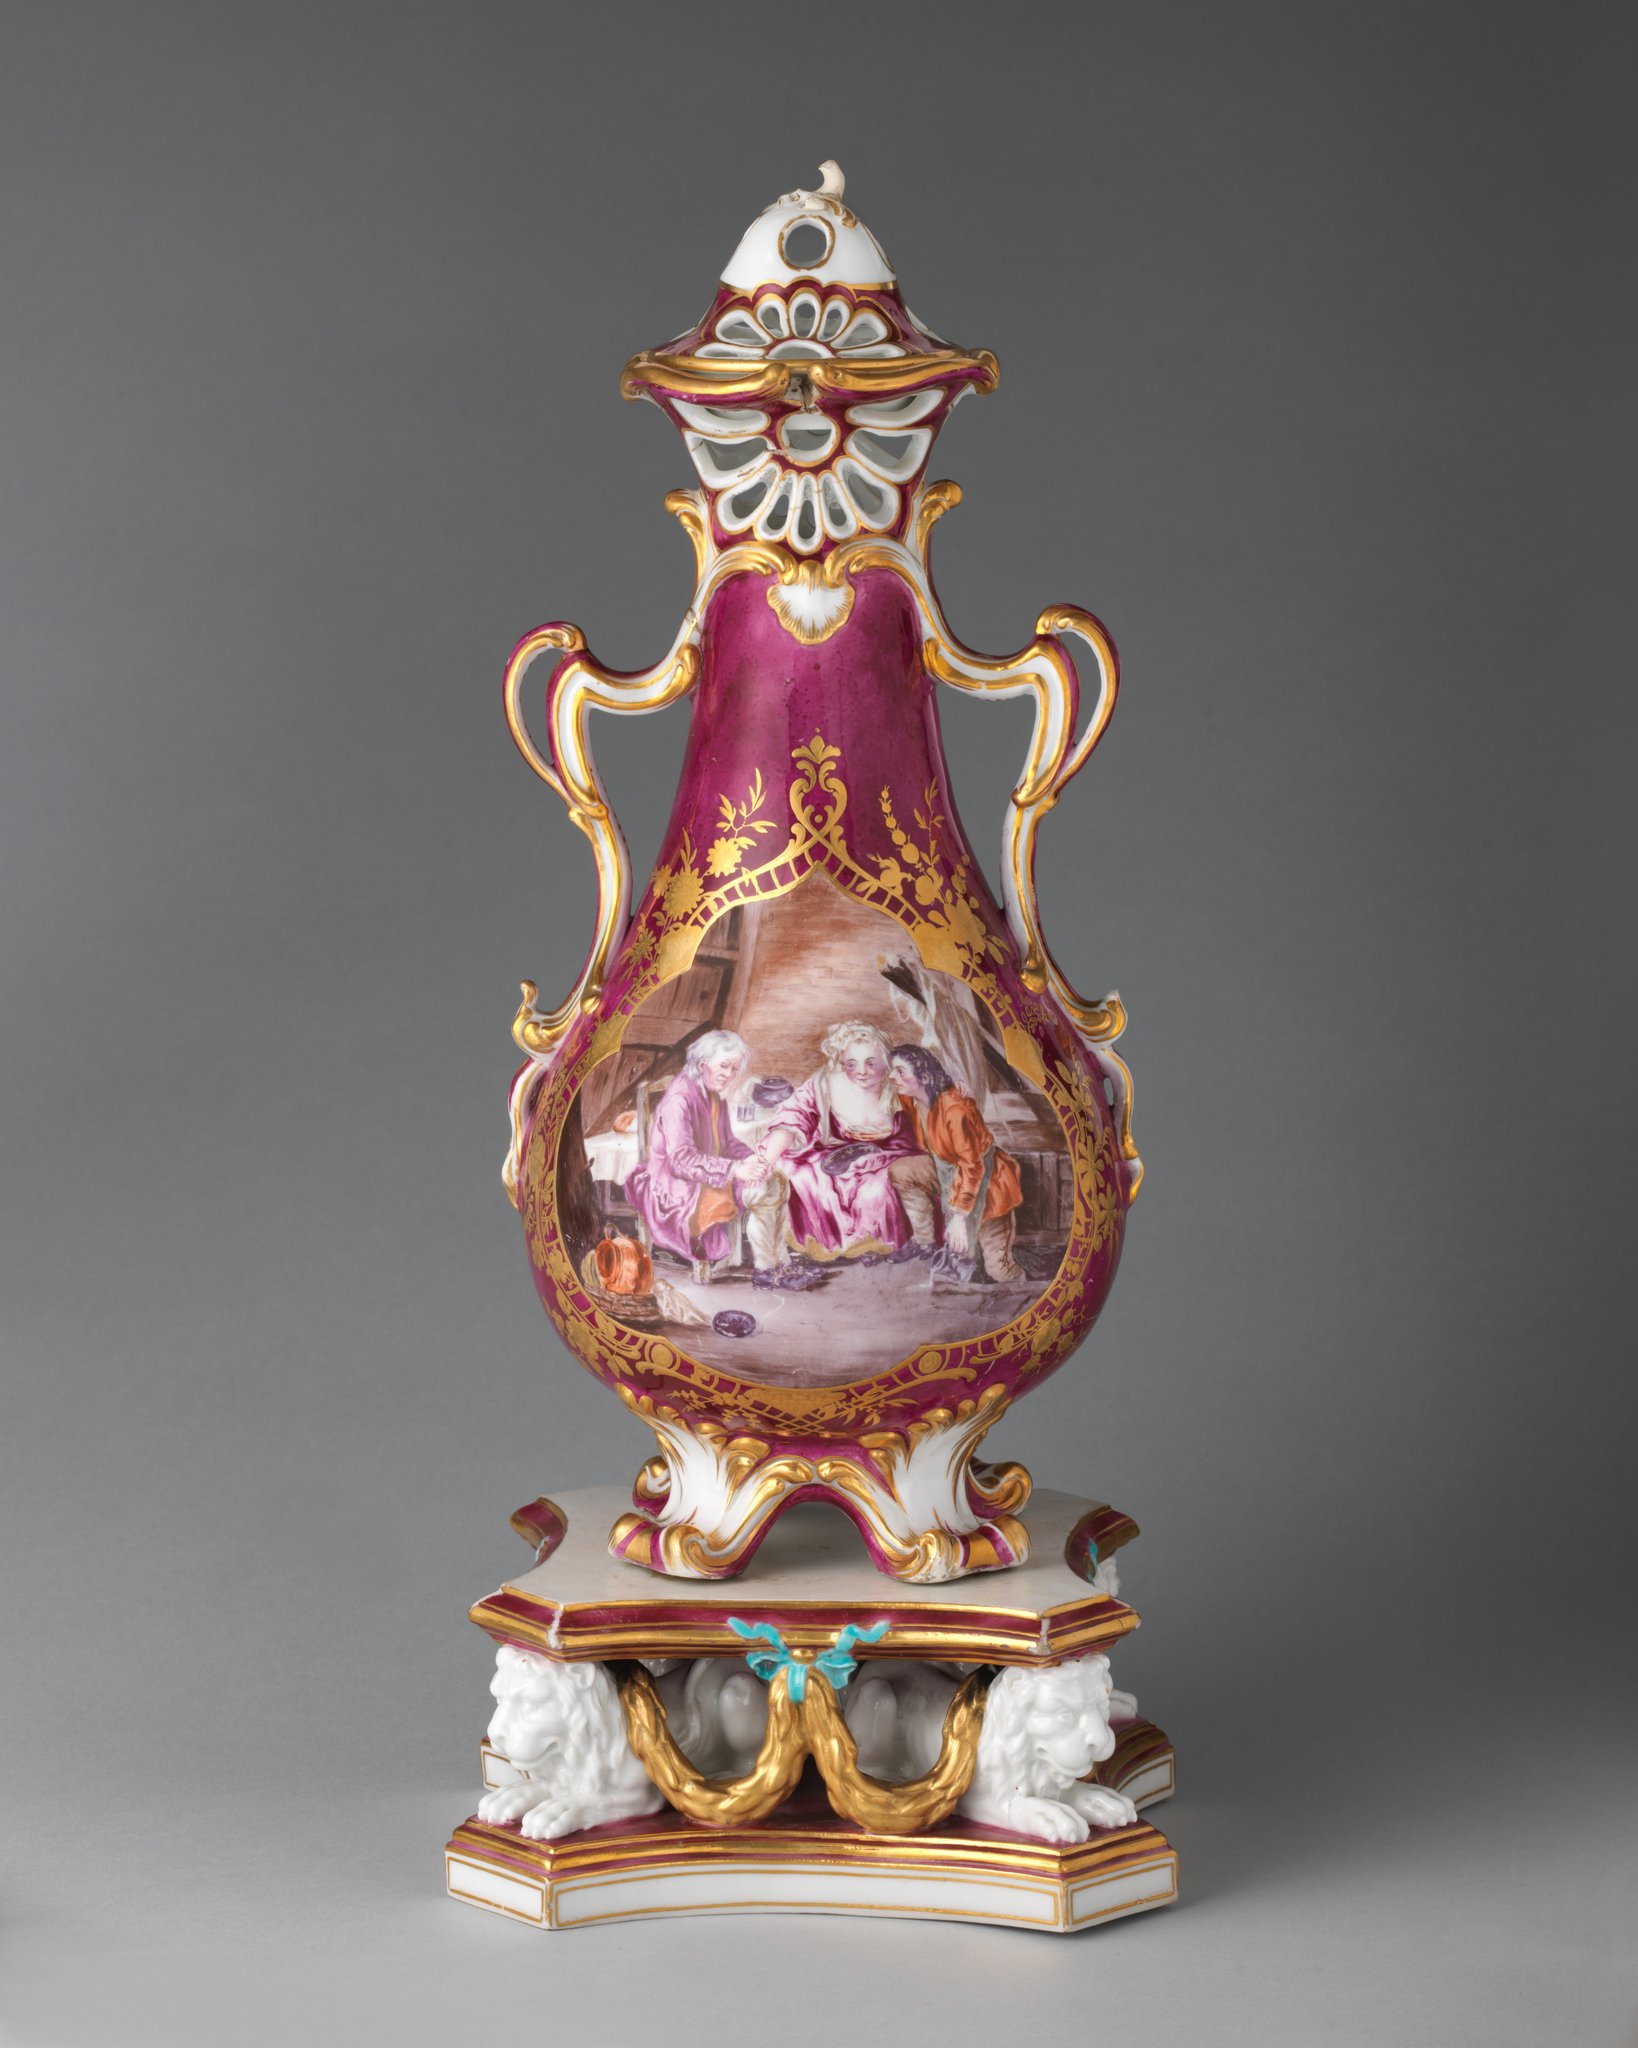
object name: perfume vase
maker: chelsea porcelain manufactory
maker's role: factory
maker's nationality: british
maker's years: 1744-1784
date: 1761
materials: soft paste porcelain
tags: men,women,lions